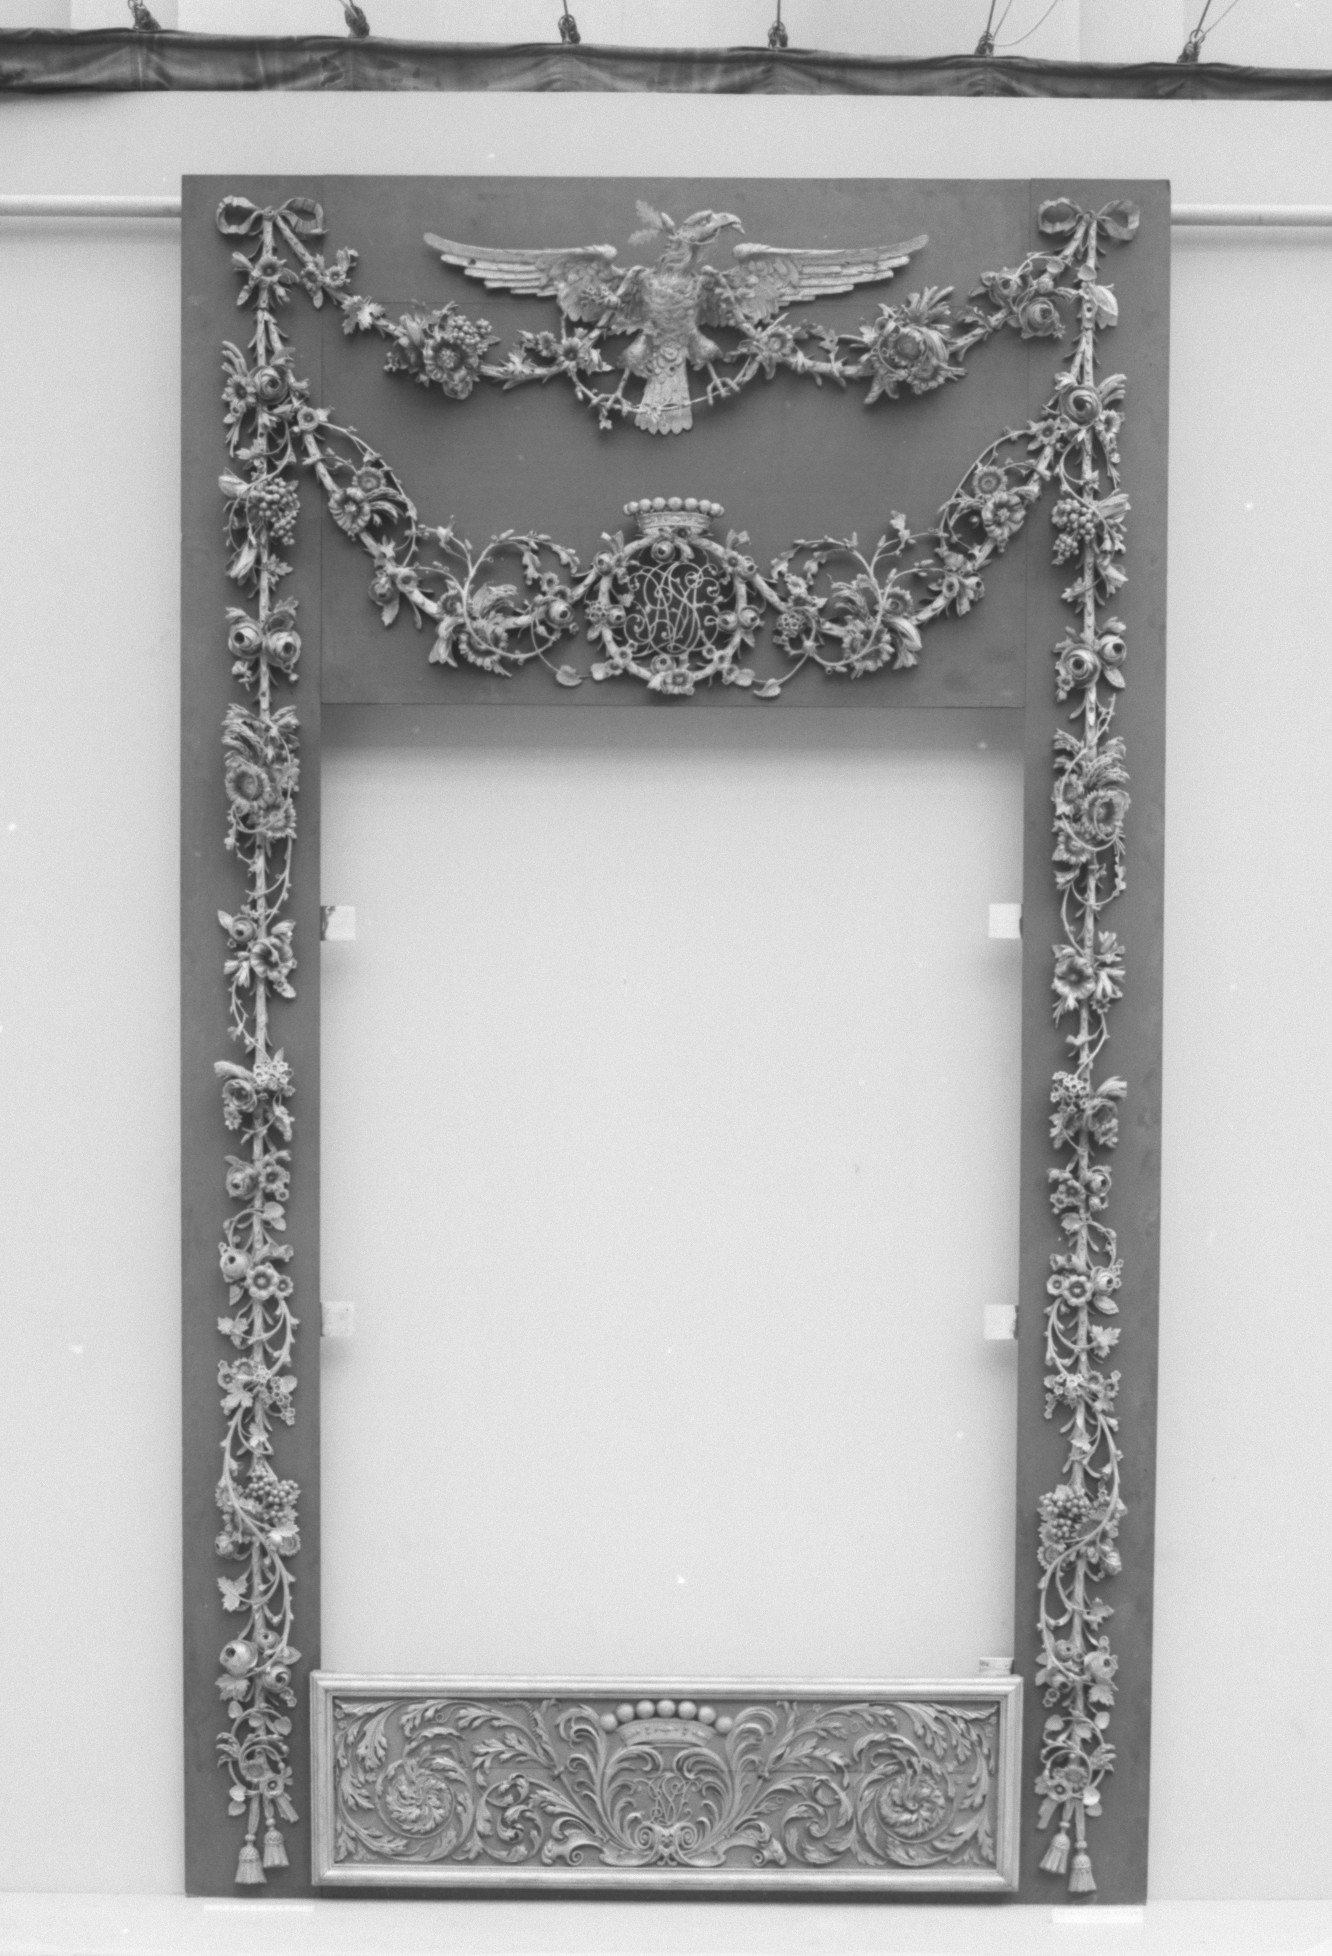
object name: overmantel carving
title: Part of a carving from an overmantel (five parts)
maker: grinling gibbons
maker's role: maker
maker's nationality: british, born the netherlands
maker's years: 1648-1721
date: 1675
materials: wood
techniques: carving, gilding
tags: eagles